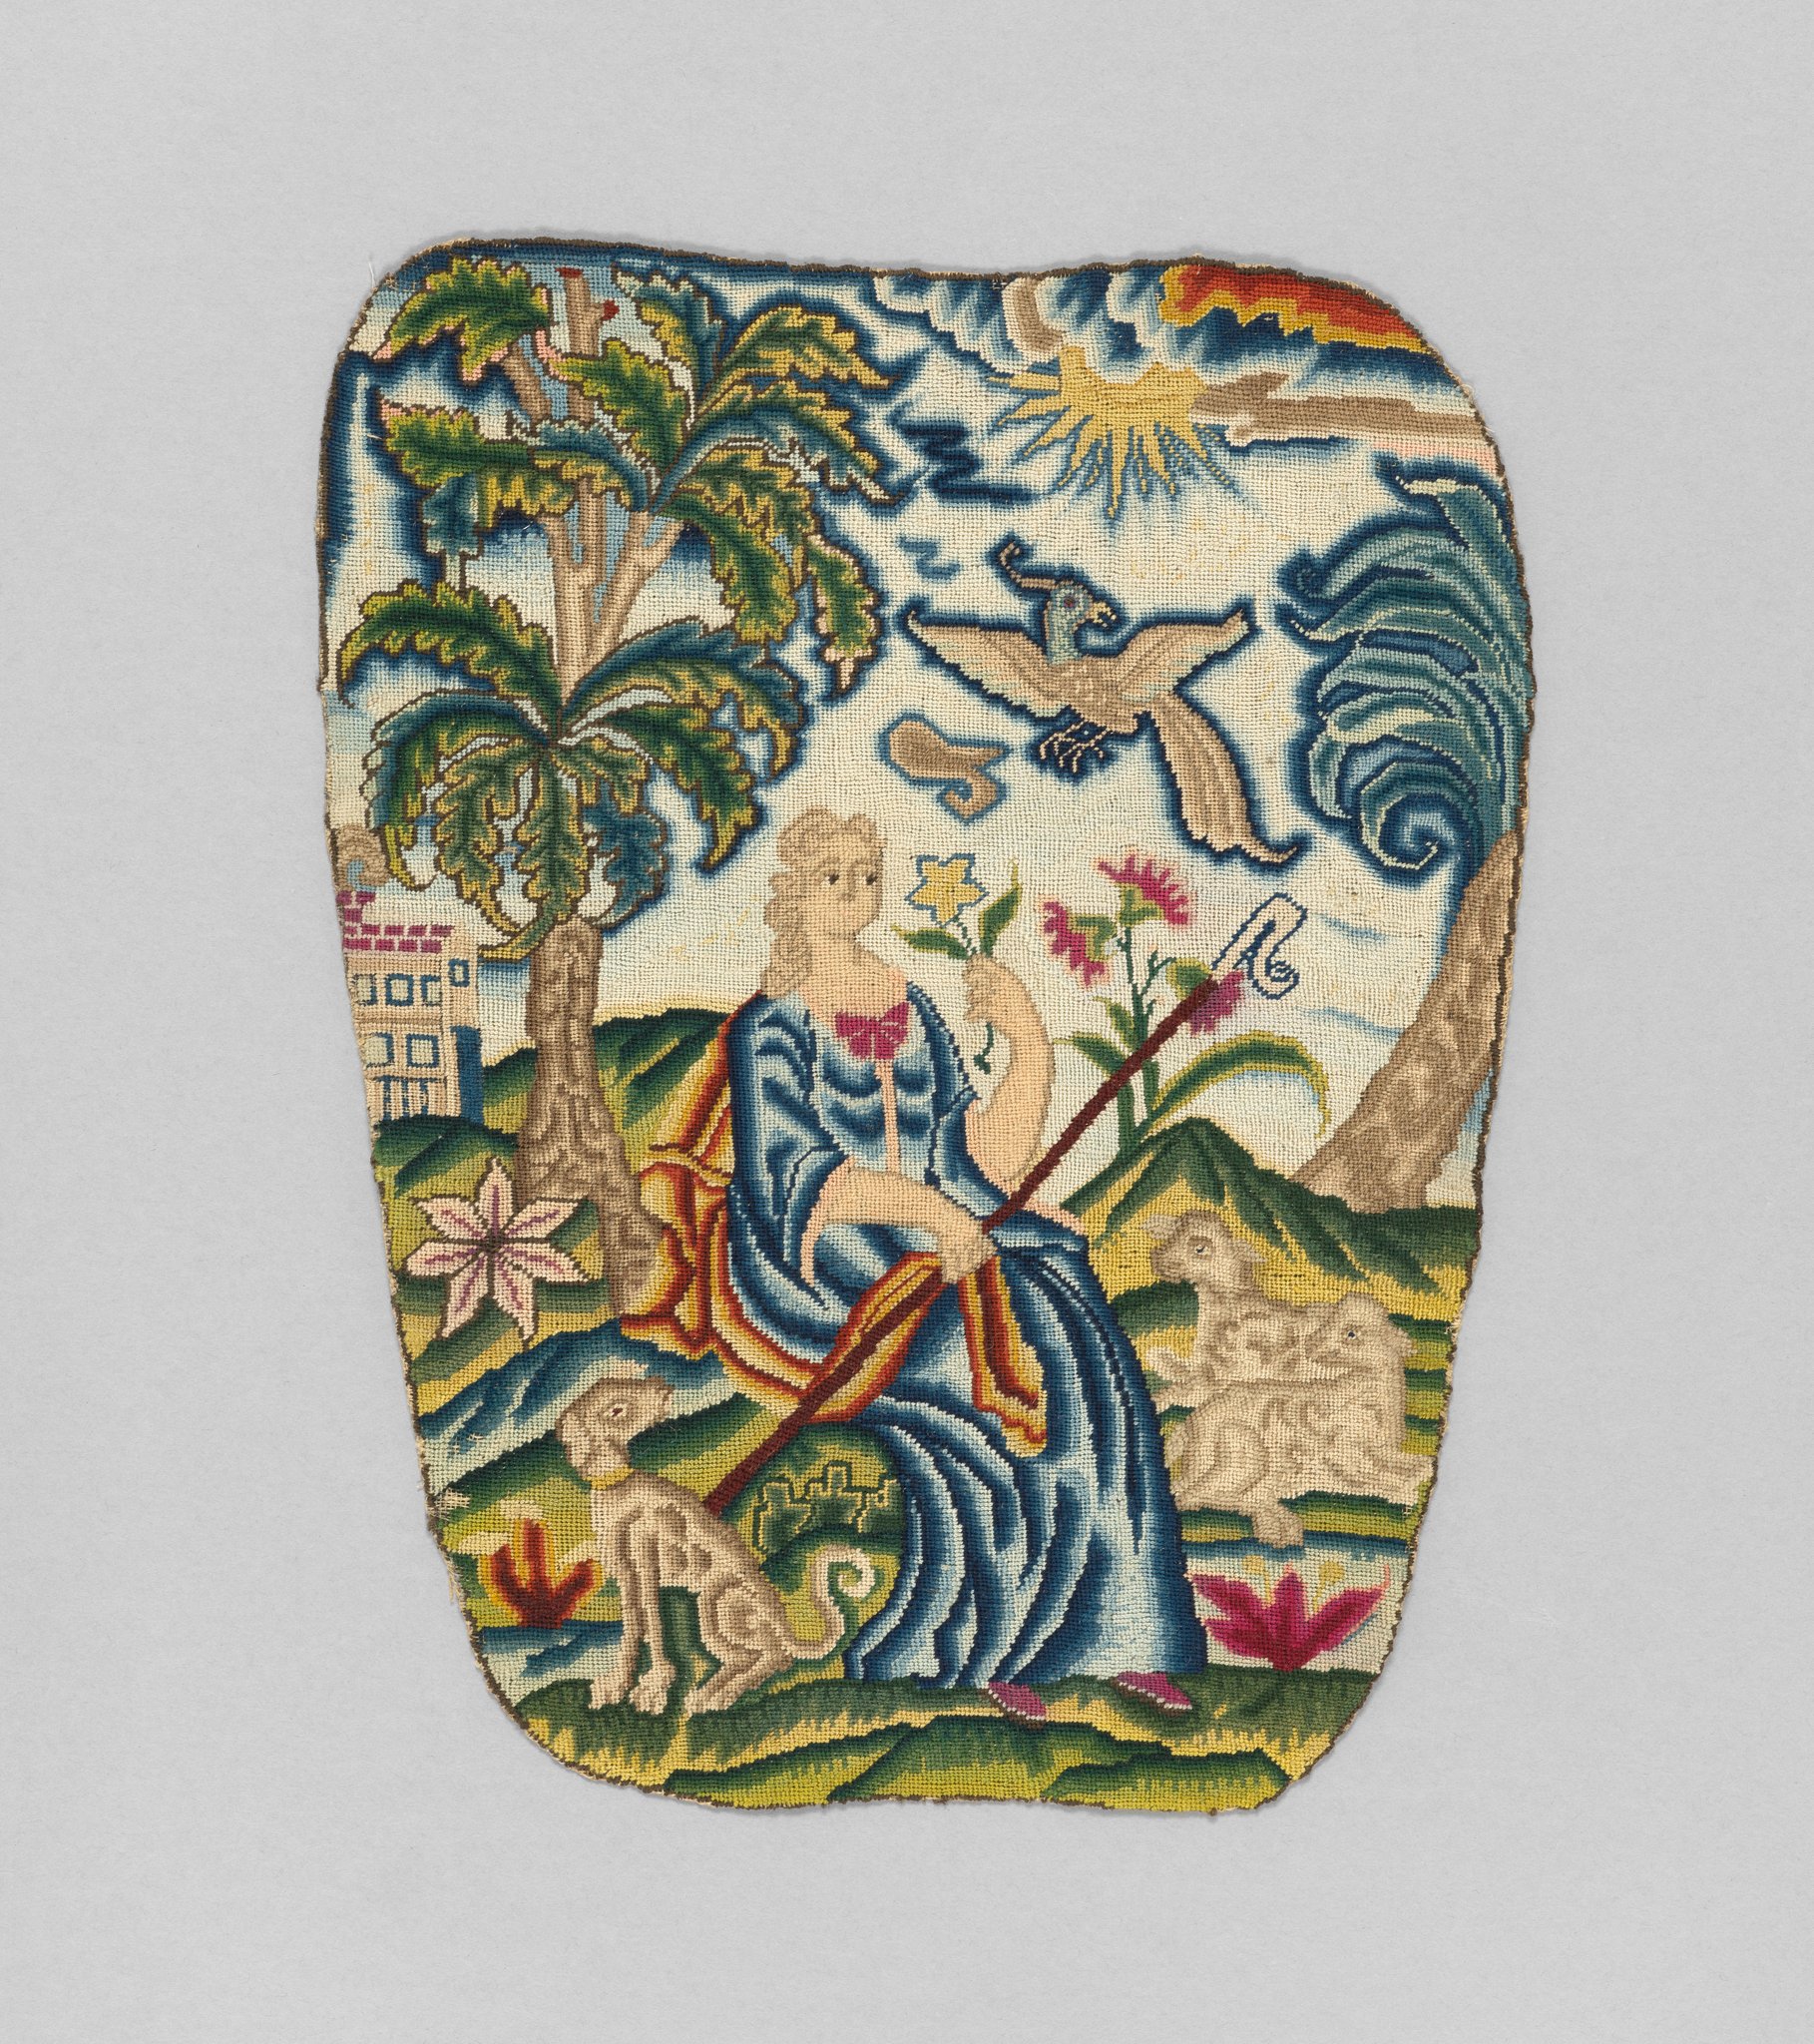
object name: hand screen panel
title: Panel for a hand screen (one of a pair)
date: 1701-1750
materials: canvas, wool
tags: birds,women,dogs,sheep,sun,trees,shepherds